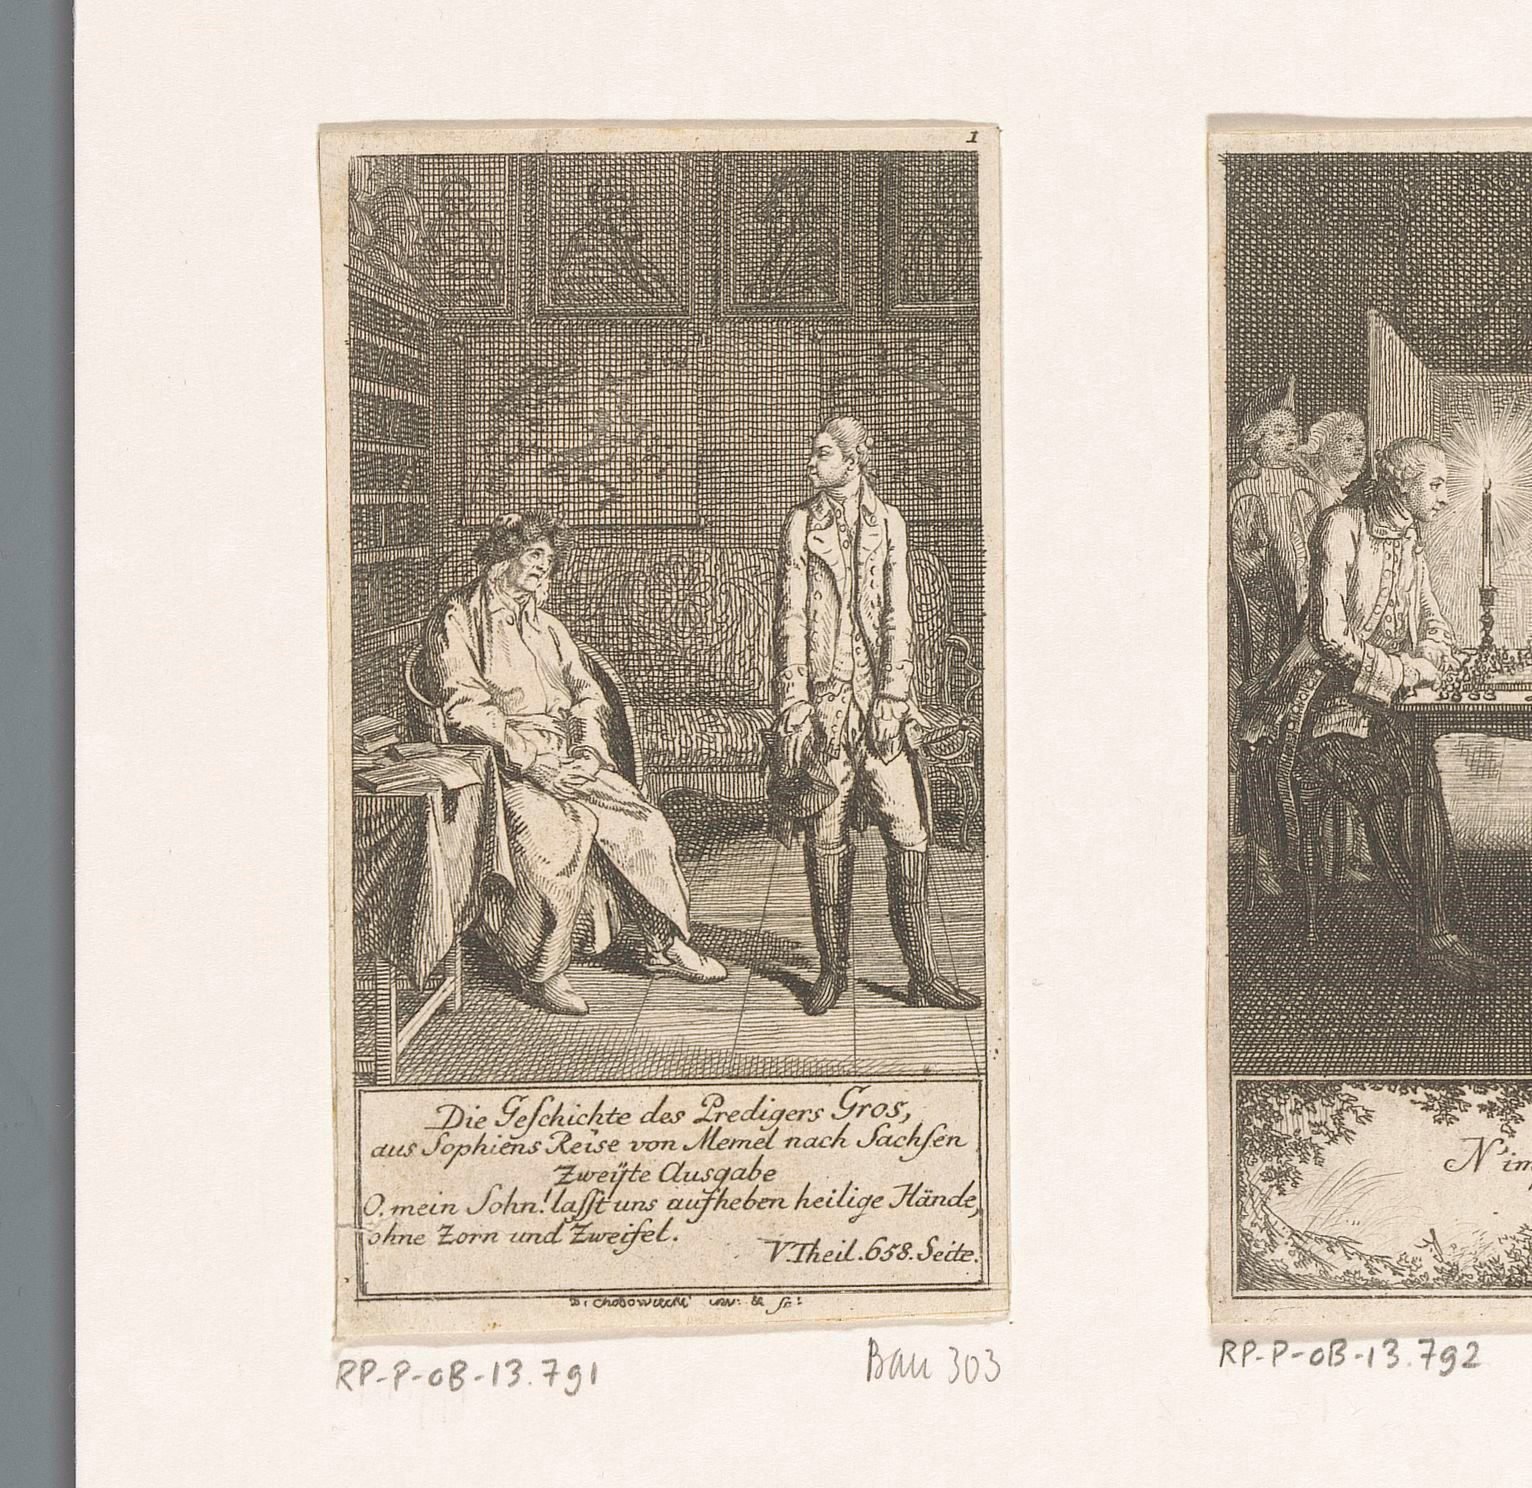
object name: print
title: Feind en zijn leraar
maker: daniel nikolaus chodowiecki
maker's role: draughtsman, print maker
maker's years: 1726-1801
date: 1776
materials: paper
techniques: etching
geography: berlin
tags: literature, scholastic education, tuition (+ teacher, professor), study; 'studiolo'; library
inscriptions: collector's mark: Lugt 2228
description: Eerste scène uit een serie van twaalf scènes die de 'Geschichte des Predigers Gros' illustreren, onderdeel van 'Sophiens Reise von Memel nach Sachsen' door Johann Timotheus Hermes. Pastor Gros von Haberstroh heet eigenlijk Karl Wagner en is de legitieme zoon van Frau E., de pleegmoeder van Sophie. Hij bedient zich ook van het alias Feind. De scènes werden op een plaat geëtst. Deze serie is ook gebruikt in: Gothaischer Hof Kalender zum Nutzen und Vergnügen eingerichtet auf das Jahr 1778. Gotha, C.W. Ettinger, s.a.